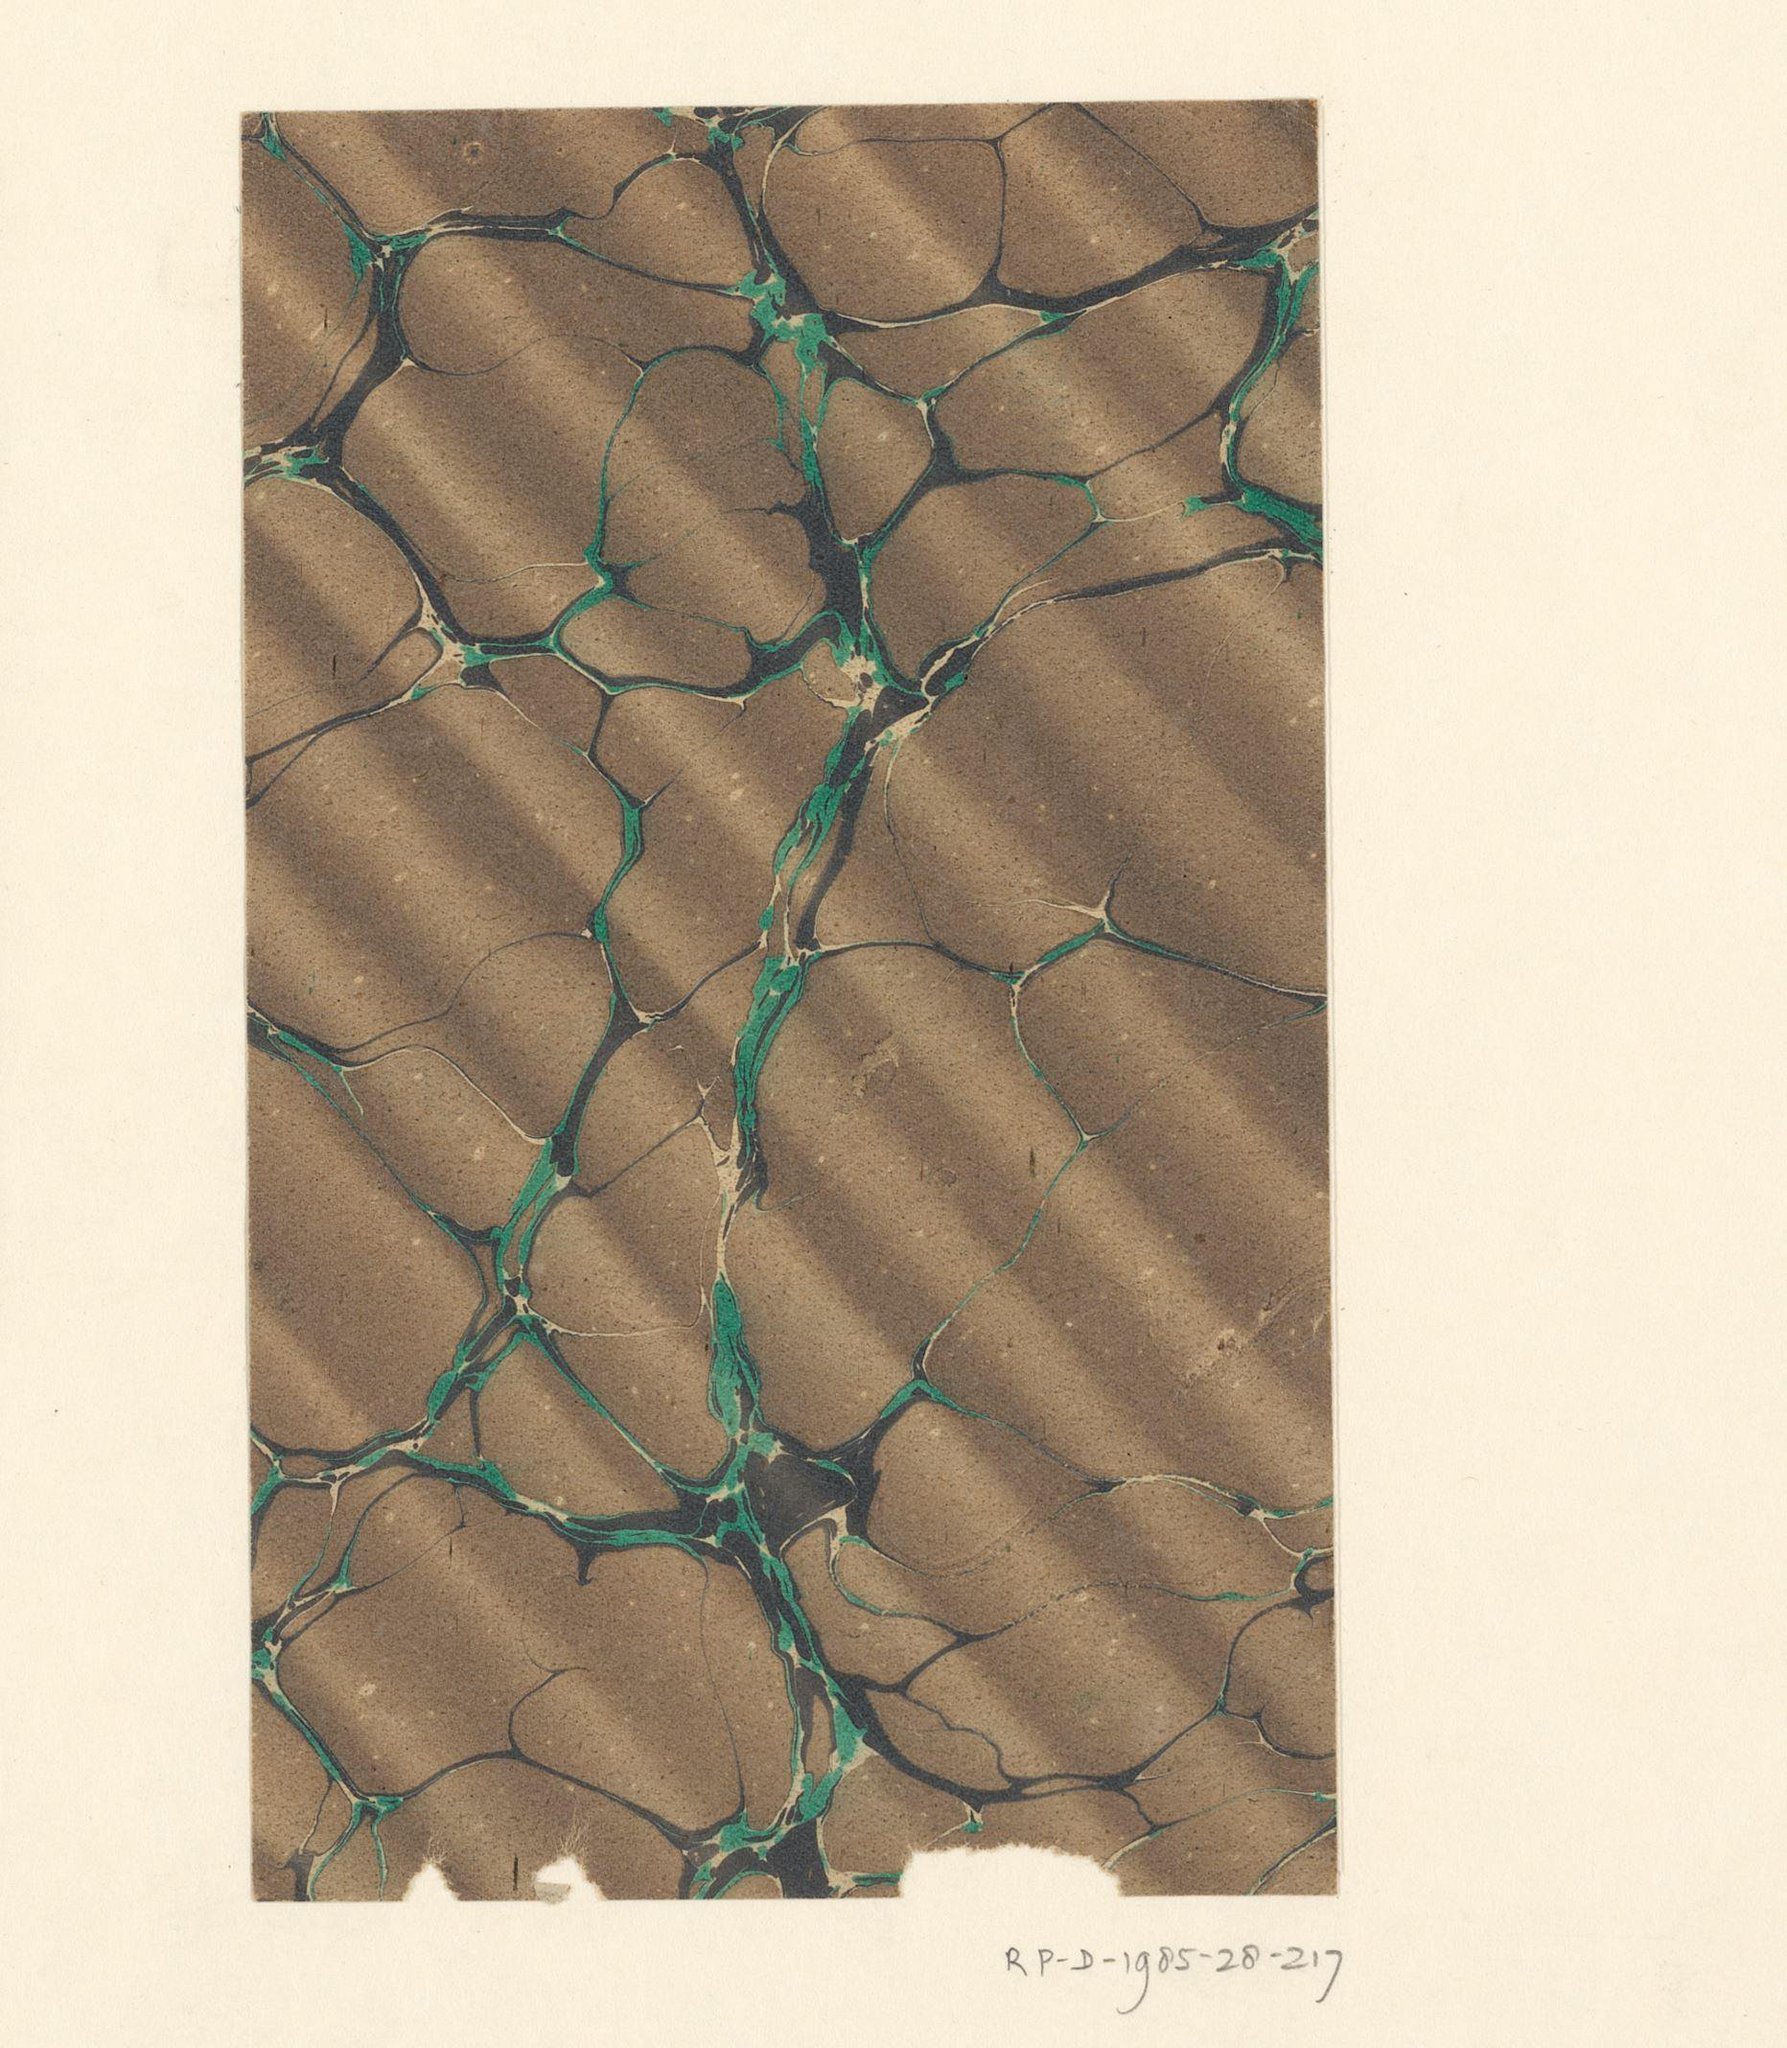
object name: marbled paper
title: Rechtschaduwmarmer in zwart, groen en lichtbruin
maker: Anonymous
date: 1700-1950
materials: lacquer, paint, paper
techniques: marbled paper, marbling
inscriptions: collector's mark: Lugt 2228, collector's mark: Lugt 2760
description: Rechtschaduwmarmer op adermarmer in bruin, groen en zwart.